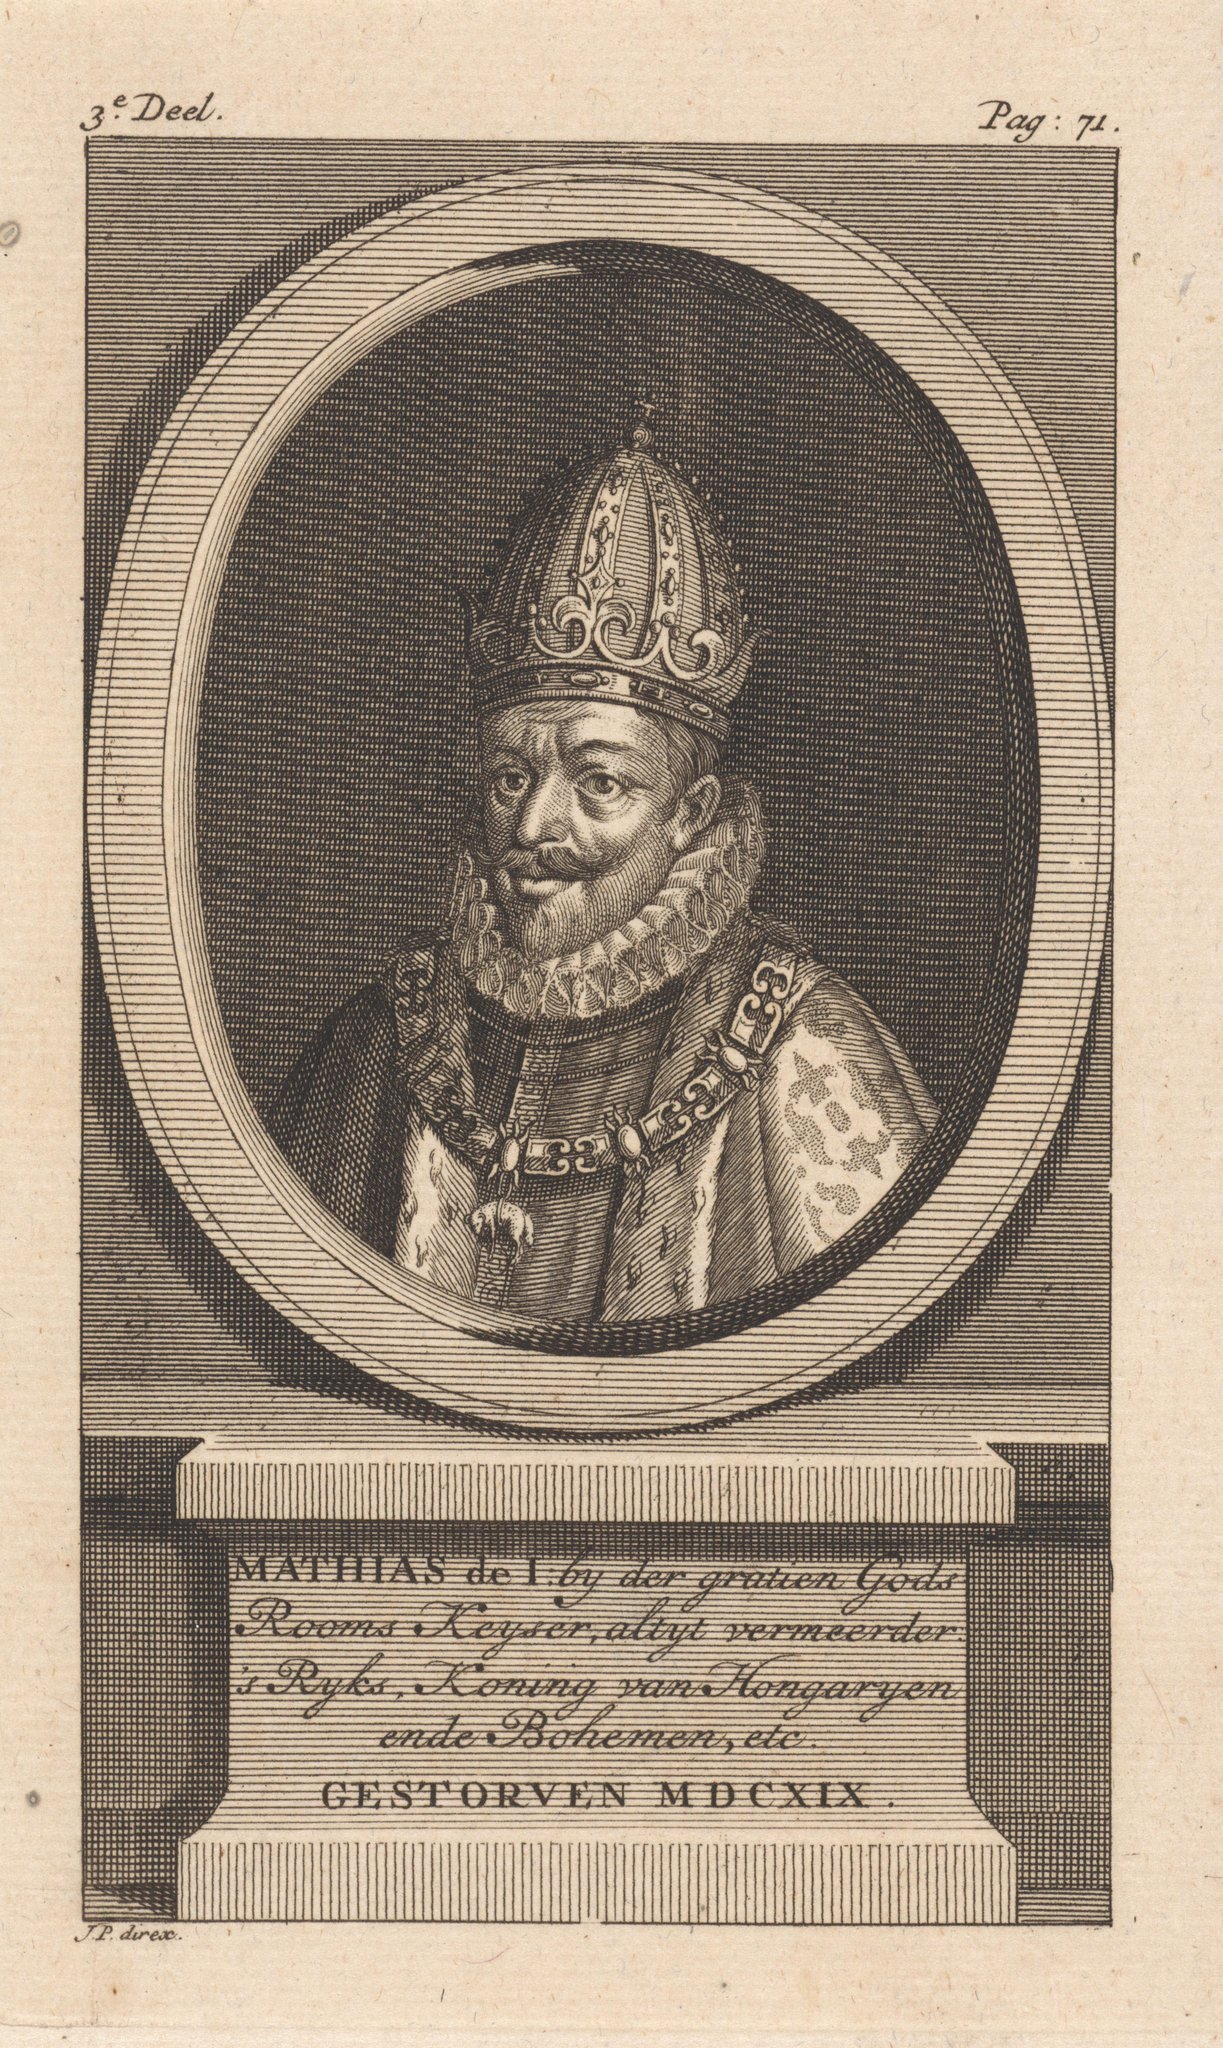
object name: book illustration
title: Portret van keizer Matthias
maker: jan punt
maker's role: draughtsman, print maker, publisher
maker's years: 1711-1779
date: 1750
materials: paper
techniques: engraving, etching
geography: northern netherlands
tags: vienna, matthias van oostenrijk (rooms-duits keizer), knighthood order of the golden fleece, emperor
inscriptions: collector's mark: Lugt 2228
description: Illustratie uit: Meteren, Emanuel van. Historie van de oorlogen en geschiedenissen der Nederlanderen, en der zelver naburen: beginnende met den jare 1315, en eindigende met den jare 1611, deel III, p. 71. Gorinchem/Breda: Nicolaas Goetzee/Willem Goetzee, 1750.